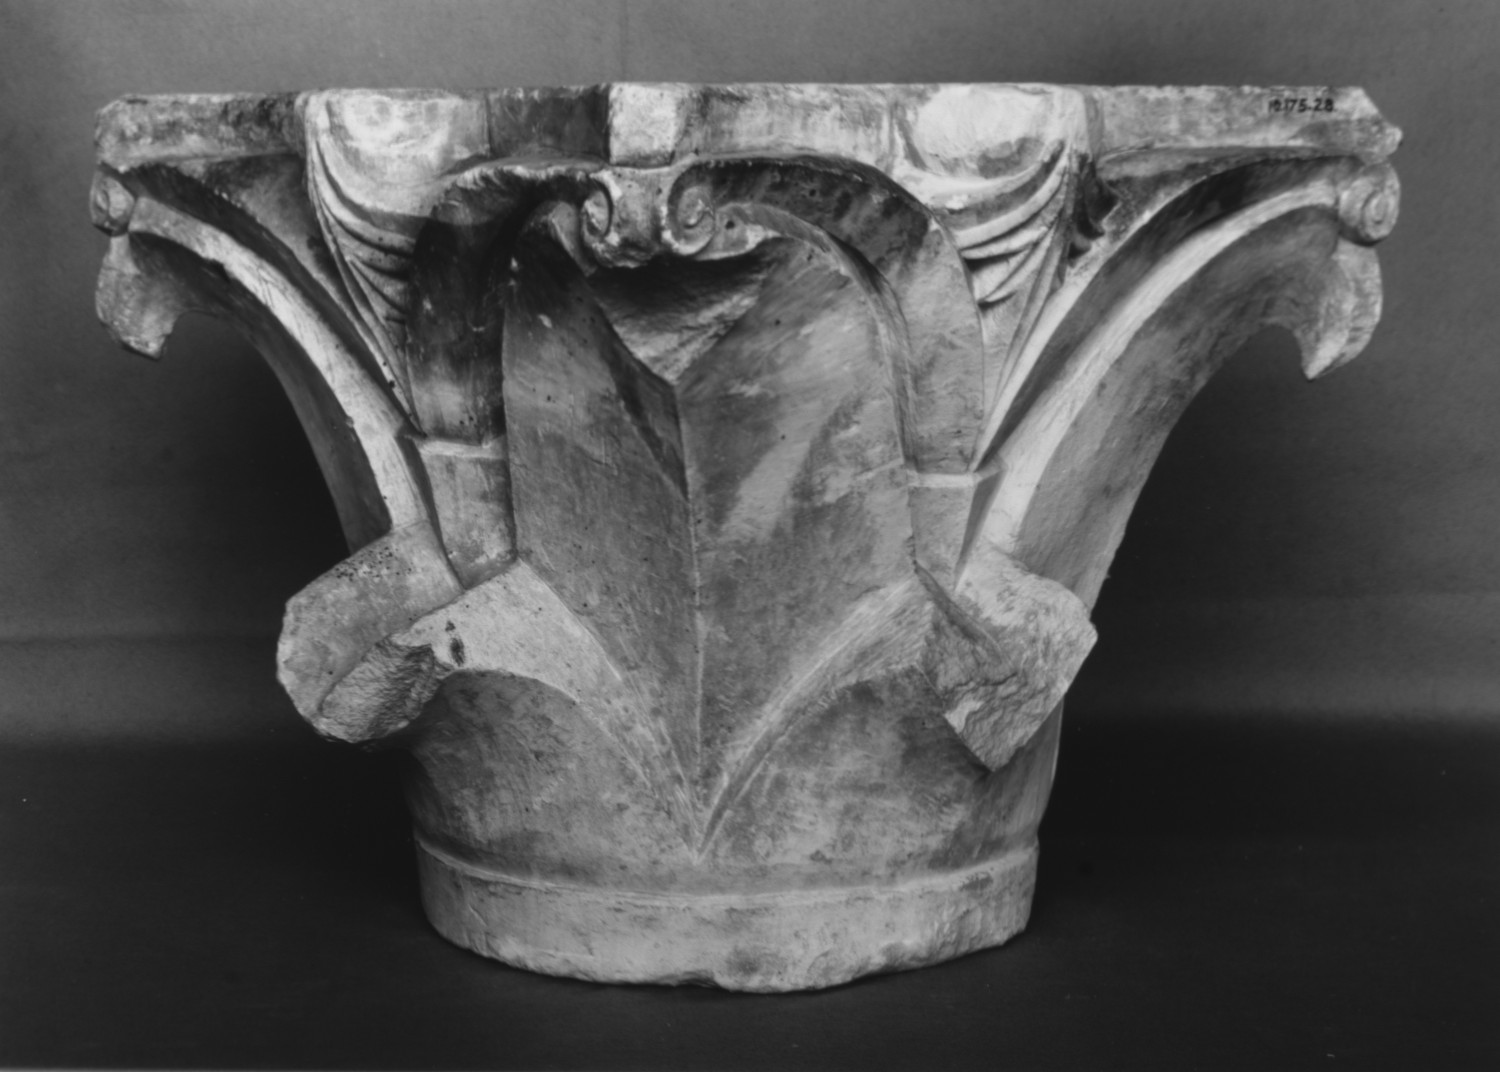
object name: capital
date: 501-700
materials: limestone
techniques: carving, relief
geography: egypt